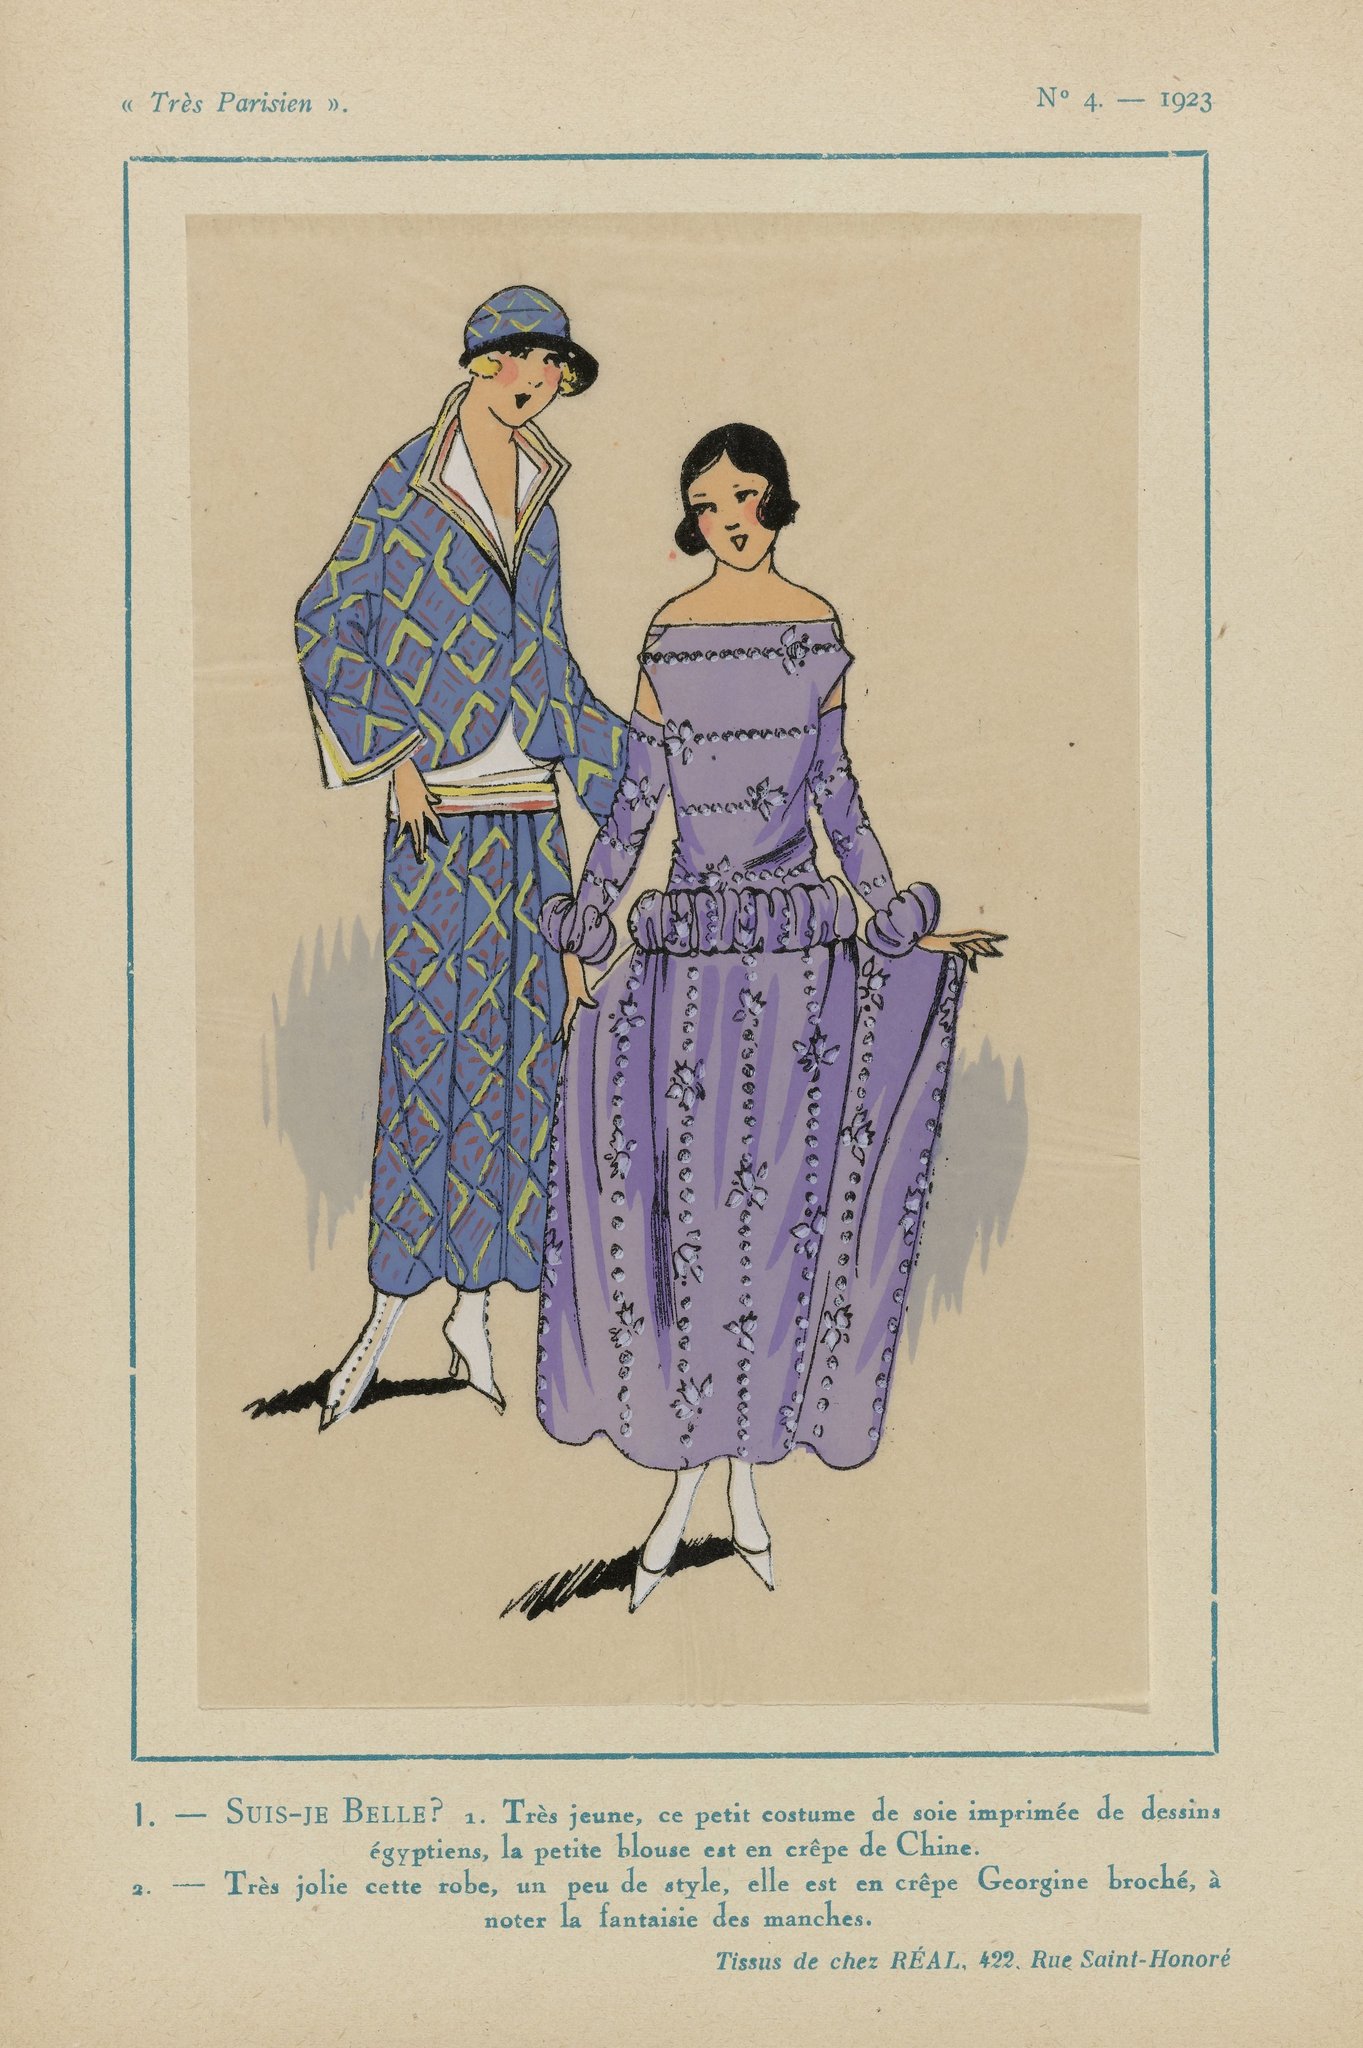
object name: fashion print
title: Très Parisien, 1923, No. 4: 1. - SUIS-JE BELLE? 1. Très jeune,...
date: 1923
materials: paper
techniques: hand coloring, letterpress printing, lithography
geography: paris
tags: clothing for the upper part of the body: blouse (+ women's clothes), dress, gown (robe de style) (+ women's clothes), fashion plates, skirt (+ women's clothes), sleeves (+ women's clothes)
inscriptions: title: ‘Très Parisien / No 4. - 1923’, caption: ‘1. - SUIS-JE BELLE? 1. Très jeune, ce petit costume de soie imprimée de dessins égyptiens, la petite blouse est en crêpe de Chine. 2. - Très jolie cette robe, un peu de style, elle est en crêpe Georgine broché, à noter la fantaisie des manches. / Tissus de chez RÉAL, 422, Rue Saint-Honoré.’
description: 1. Een kostuum van zijde, bedrukt met egyptische motieven. De blouse is van crêpe de Chine. 2. Jurk, 'un peu de style', van gebrocheerde crêpe Georgette, met bijzondere mouwen. Prent uit het modetijdschrift Très Parisien (1920-1936).